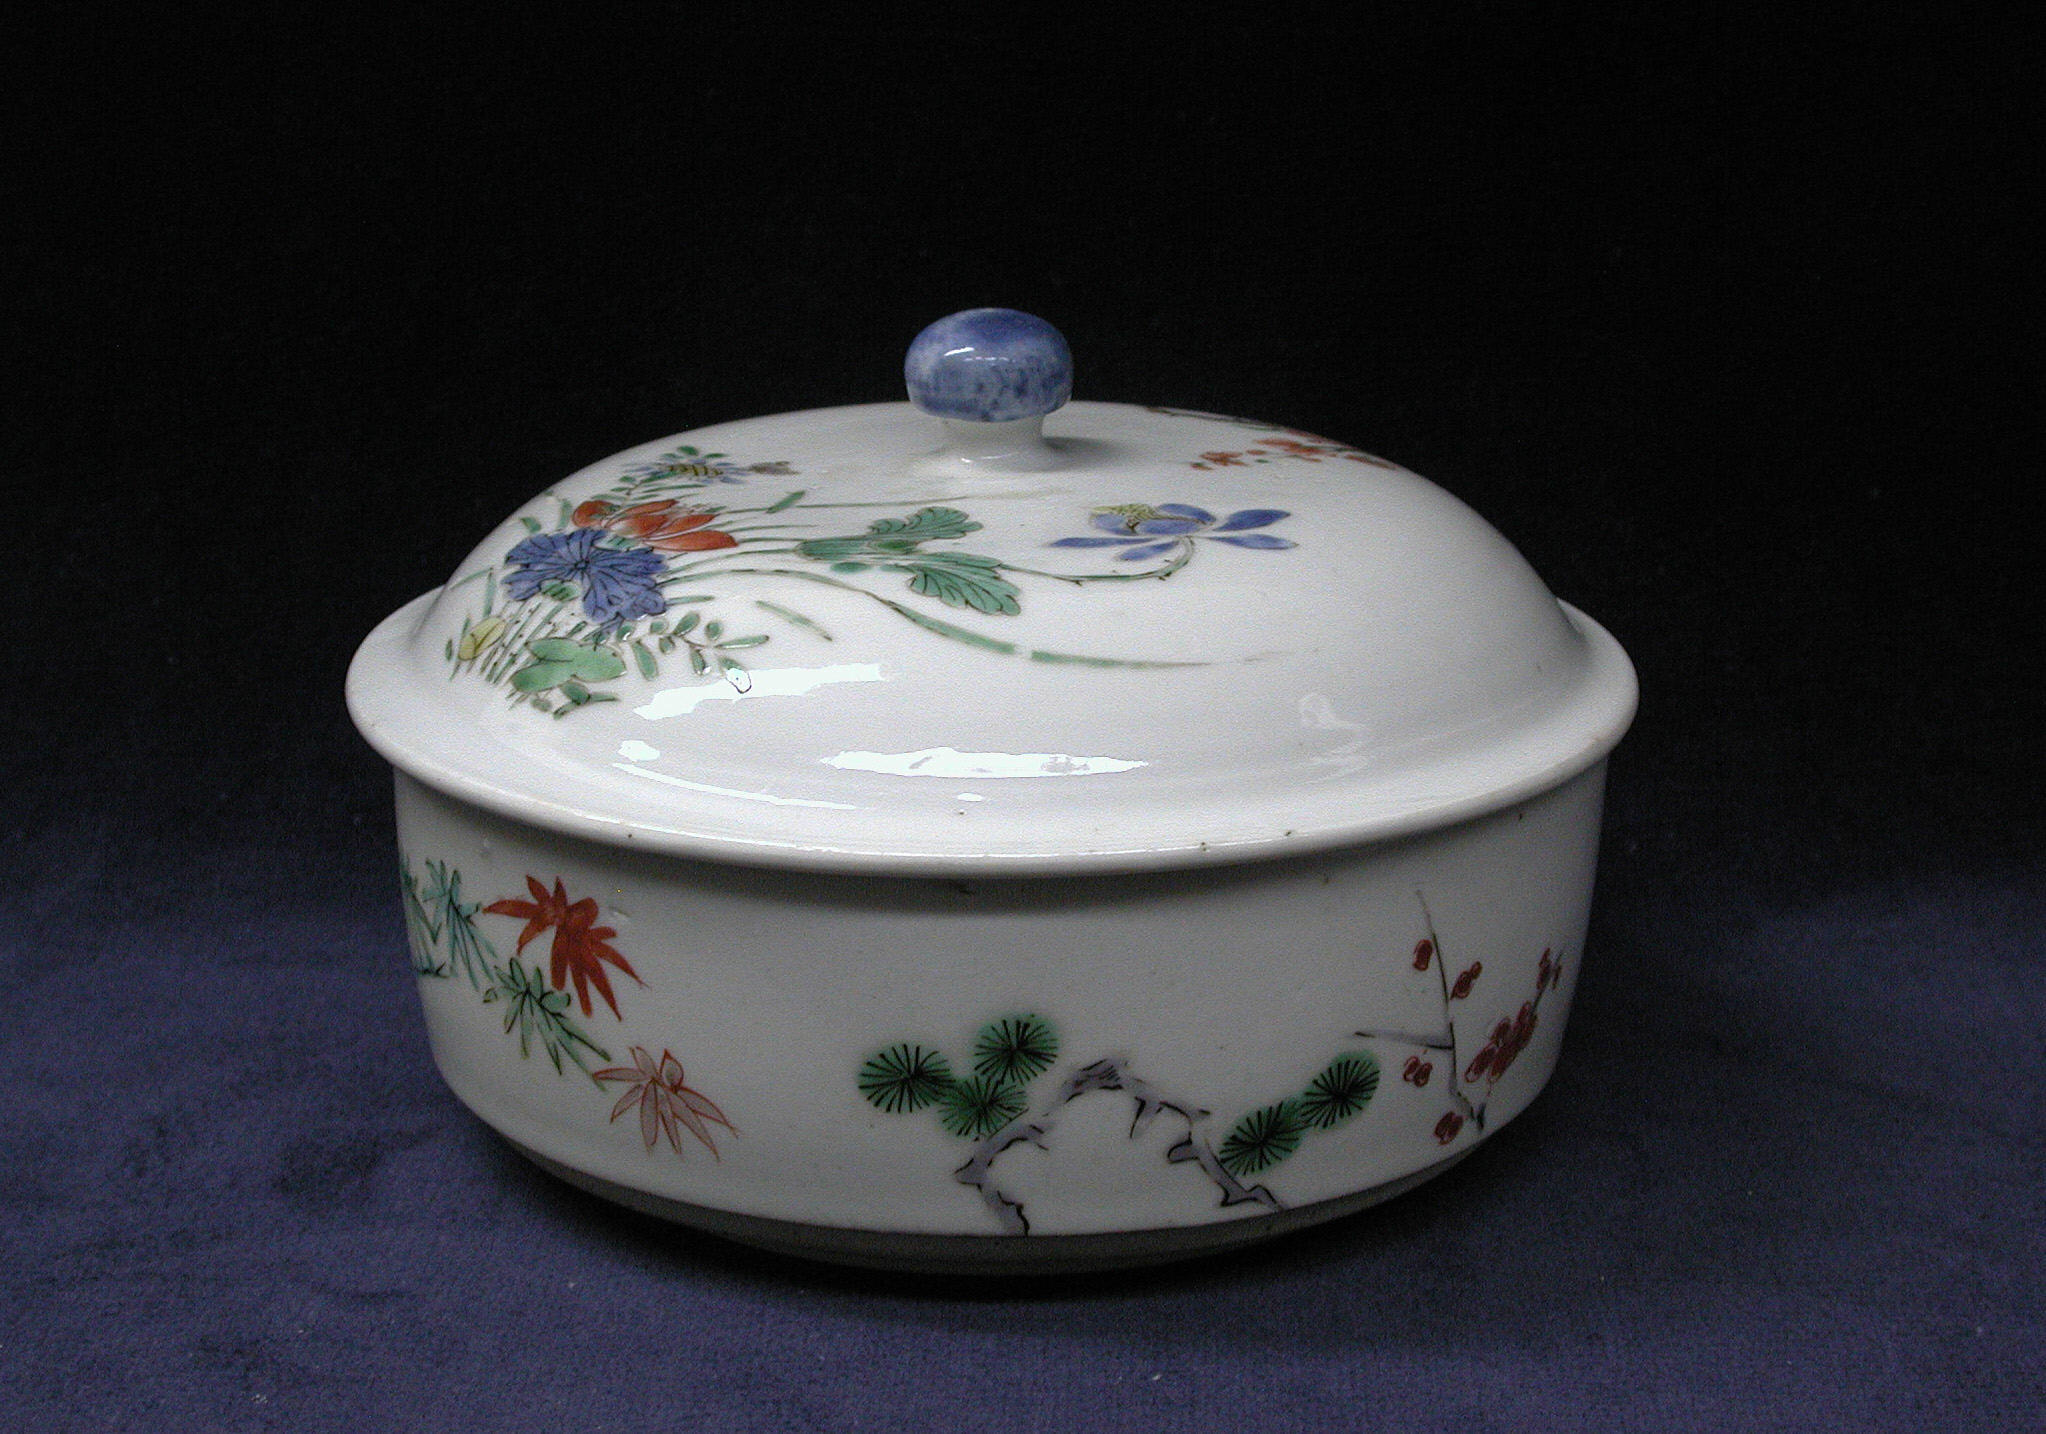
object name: cover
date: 1701-1725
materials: hard paste porcelain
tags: flowers